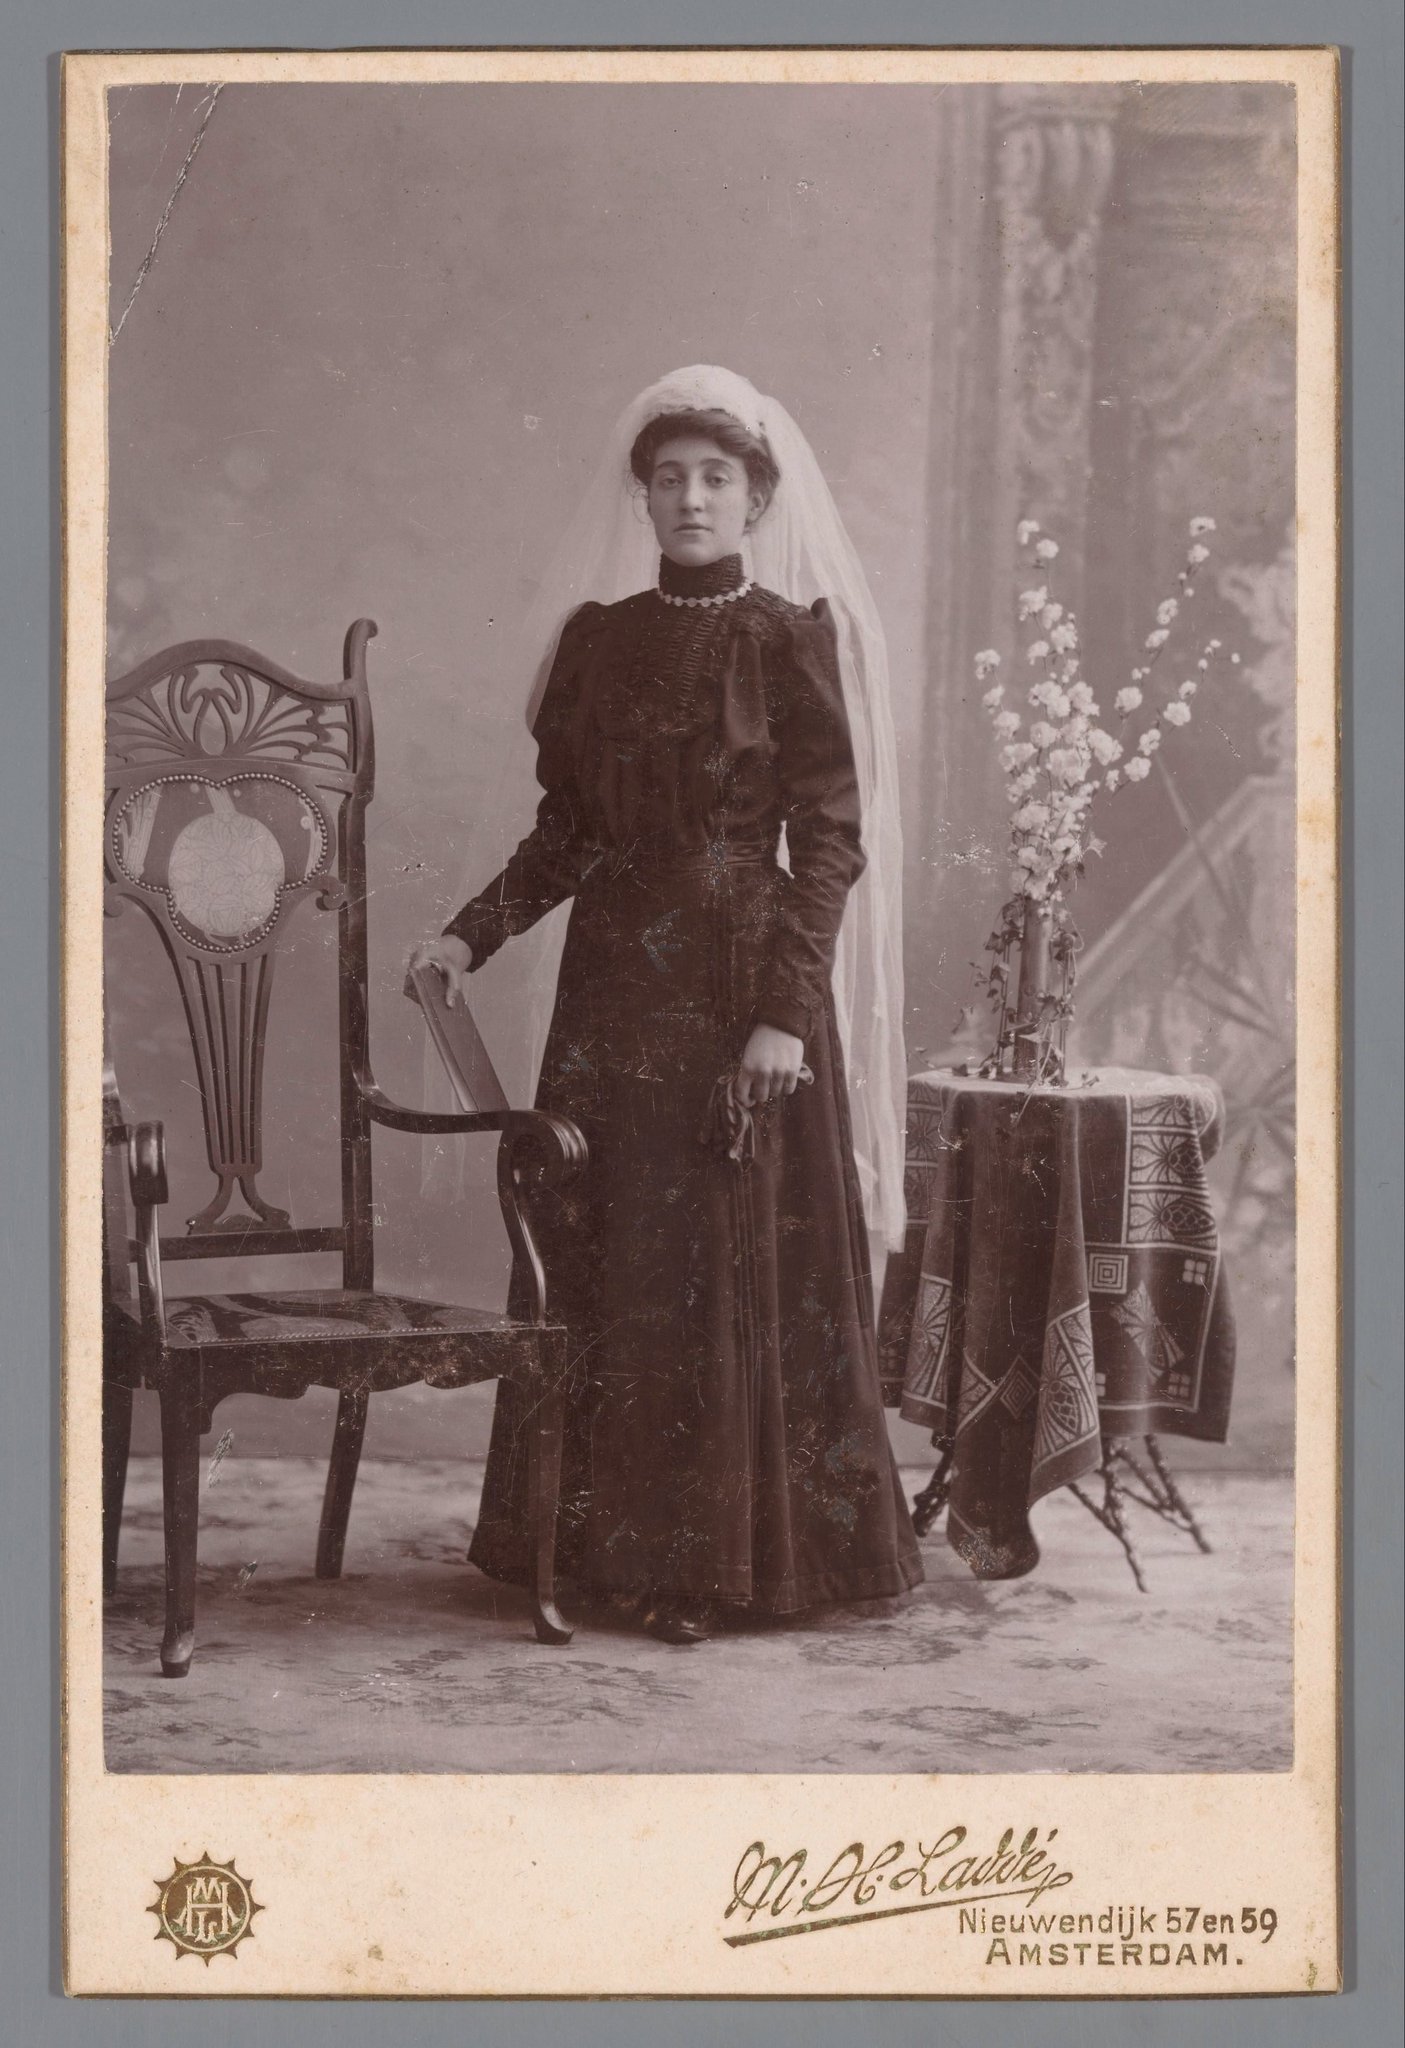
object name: cabinet photograph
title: Portret van een onbekende vrouw in een donkere jurk en met een witte sluier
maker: machiel hendricus laddé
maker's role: fotograaf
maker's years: 1866-1932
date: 1892-1906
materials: cardboard, photographic support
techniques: daylight paper print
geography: amsterdam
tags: adult woman, veil